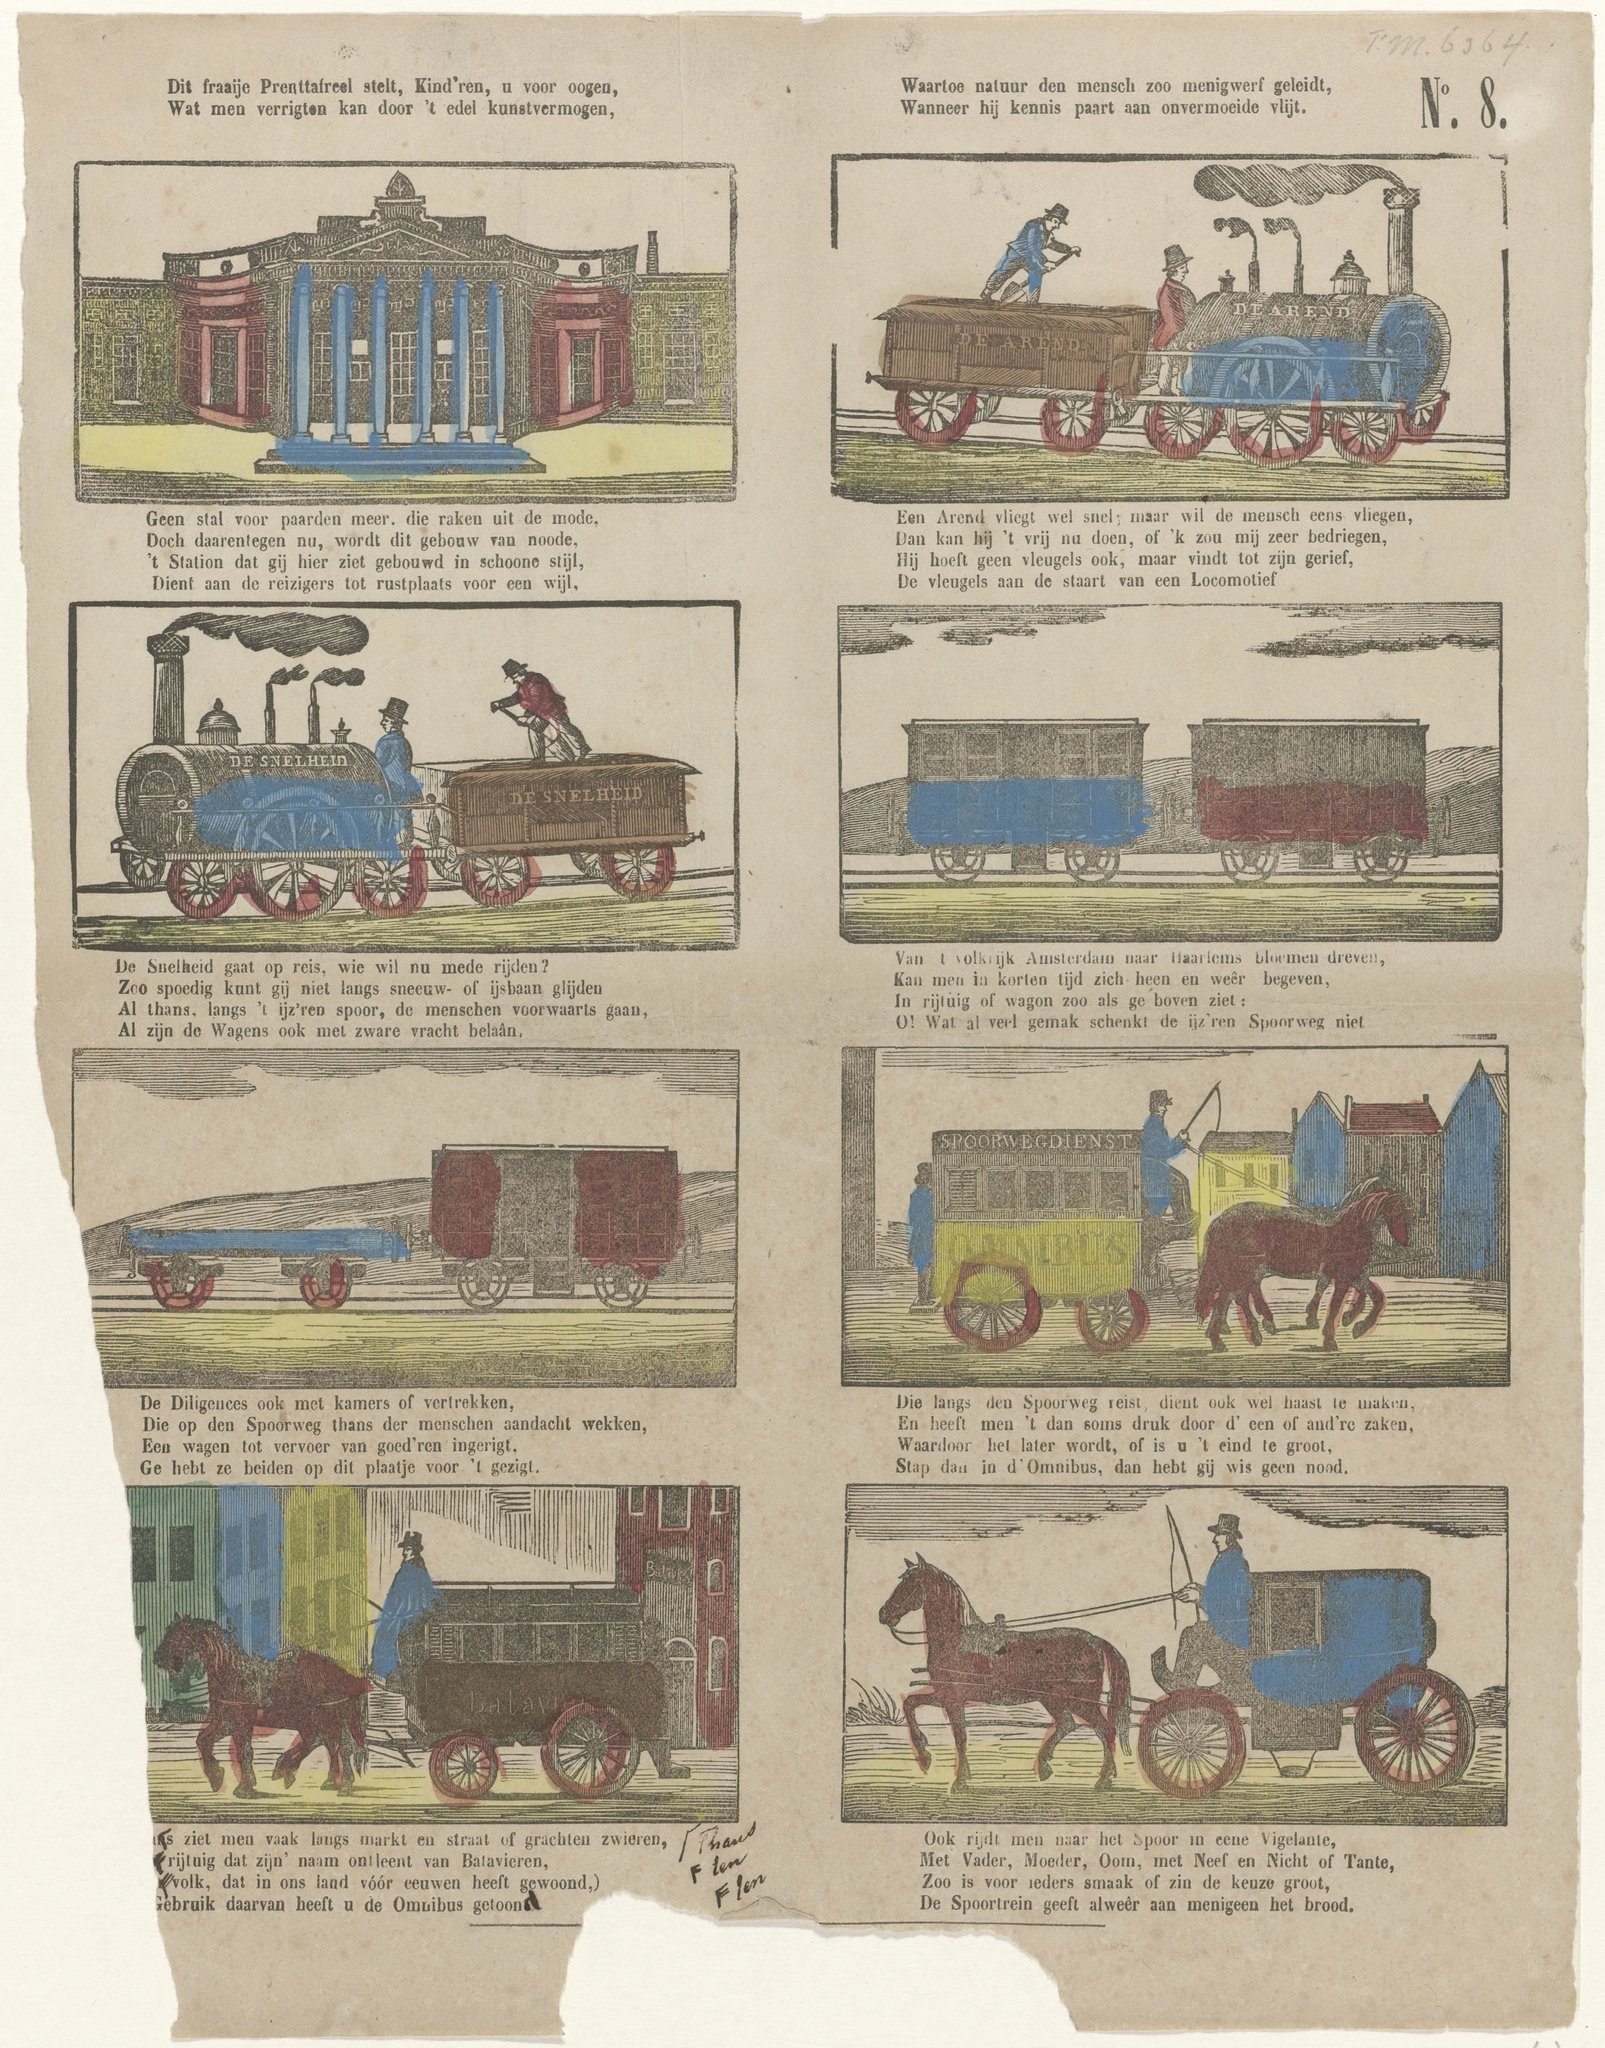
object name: popular print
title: Dit fraaije Prenttafereel stelt, Kind'ren, u voor oogen, / Wat men verrigten kan door 't edel kunstvermogen (...)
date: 1856-1858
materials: paper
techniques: colour, letterpress printing, engraving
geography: amsterdam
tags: diligence, omnibus, horse-tram, railway, train, station; shelter (railway, tramway)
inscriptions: collector's mark: Lugt 2228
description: Deze prent besteedt, ten behoeve van de jeugd, aandacht aan drie vormen van vervoer die in 1839 in dienst traden. De eerste spoorlijn in Nederland, die vanaf het treinstation bij herberg d’Eenhonderd Roe buiten Amsterdam naar Haarlem liep. De dienst werd onderhouden met de twee stoomlocomotieven genaamd ‘De Arend’ en ‘De Snelheid’. Hetzelfde jaar startten twee omnibus-maatschappijen in Amsterdam; een paardenbus met vaste routes en vaste vertrektijden. De ene werd gedreven door de ‘Amsterdamse Omnibus Onderneming’ (tot 1848), de andere heette ‘De Batavier’ (tot 1840). In deze latere versie van de prent is station d'Eenhonderd Roe vervangen door station Willemspoort, dat 1842-43 opende en dichter bij Amsterdam lag. Op deze afdruk is het adres van de uitgever afgeknipt (midden onder).